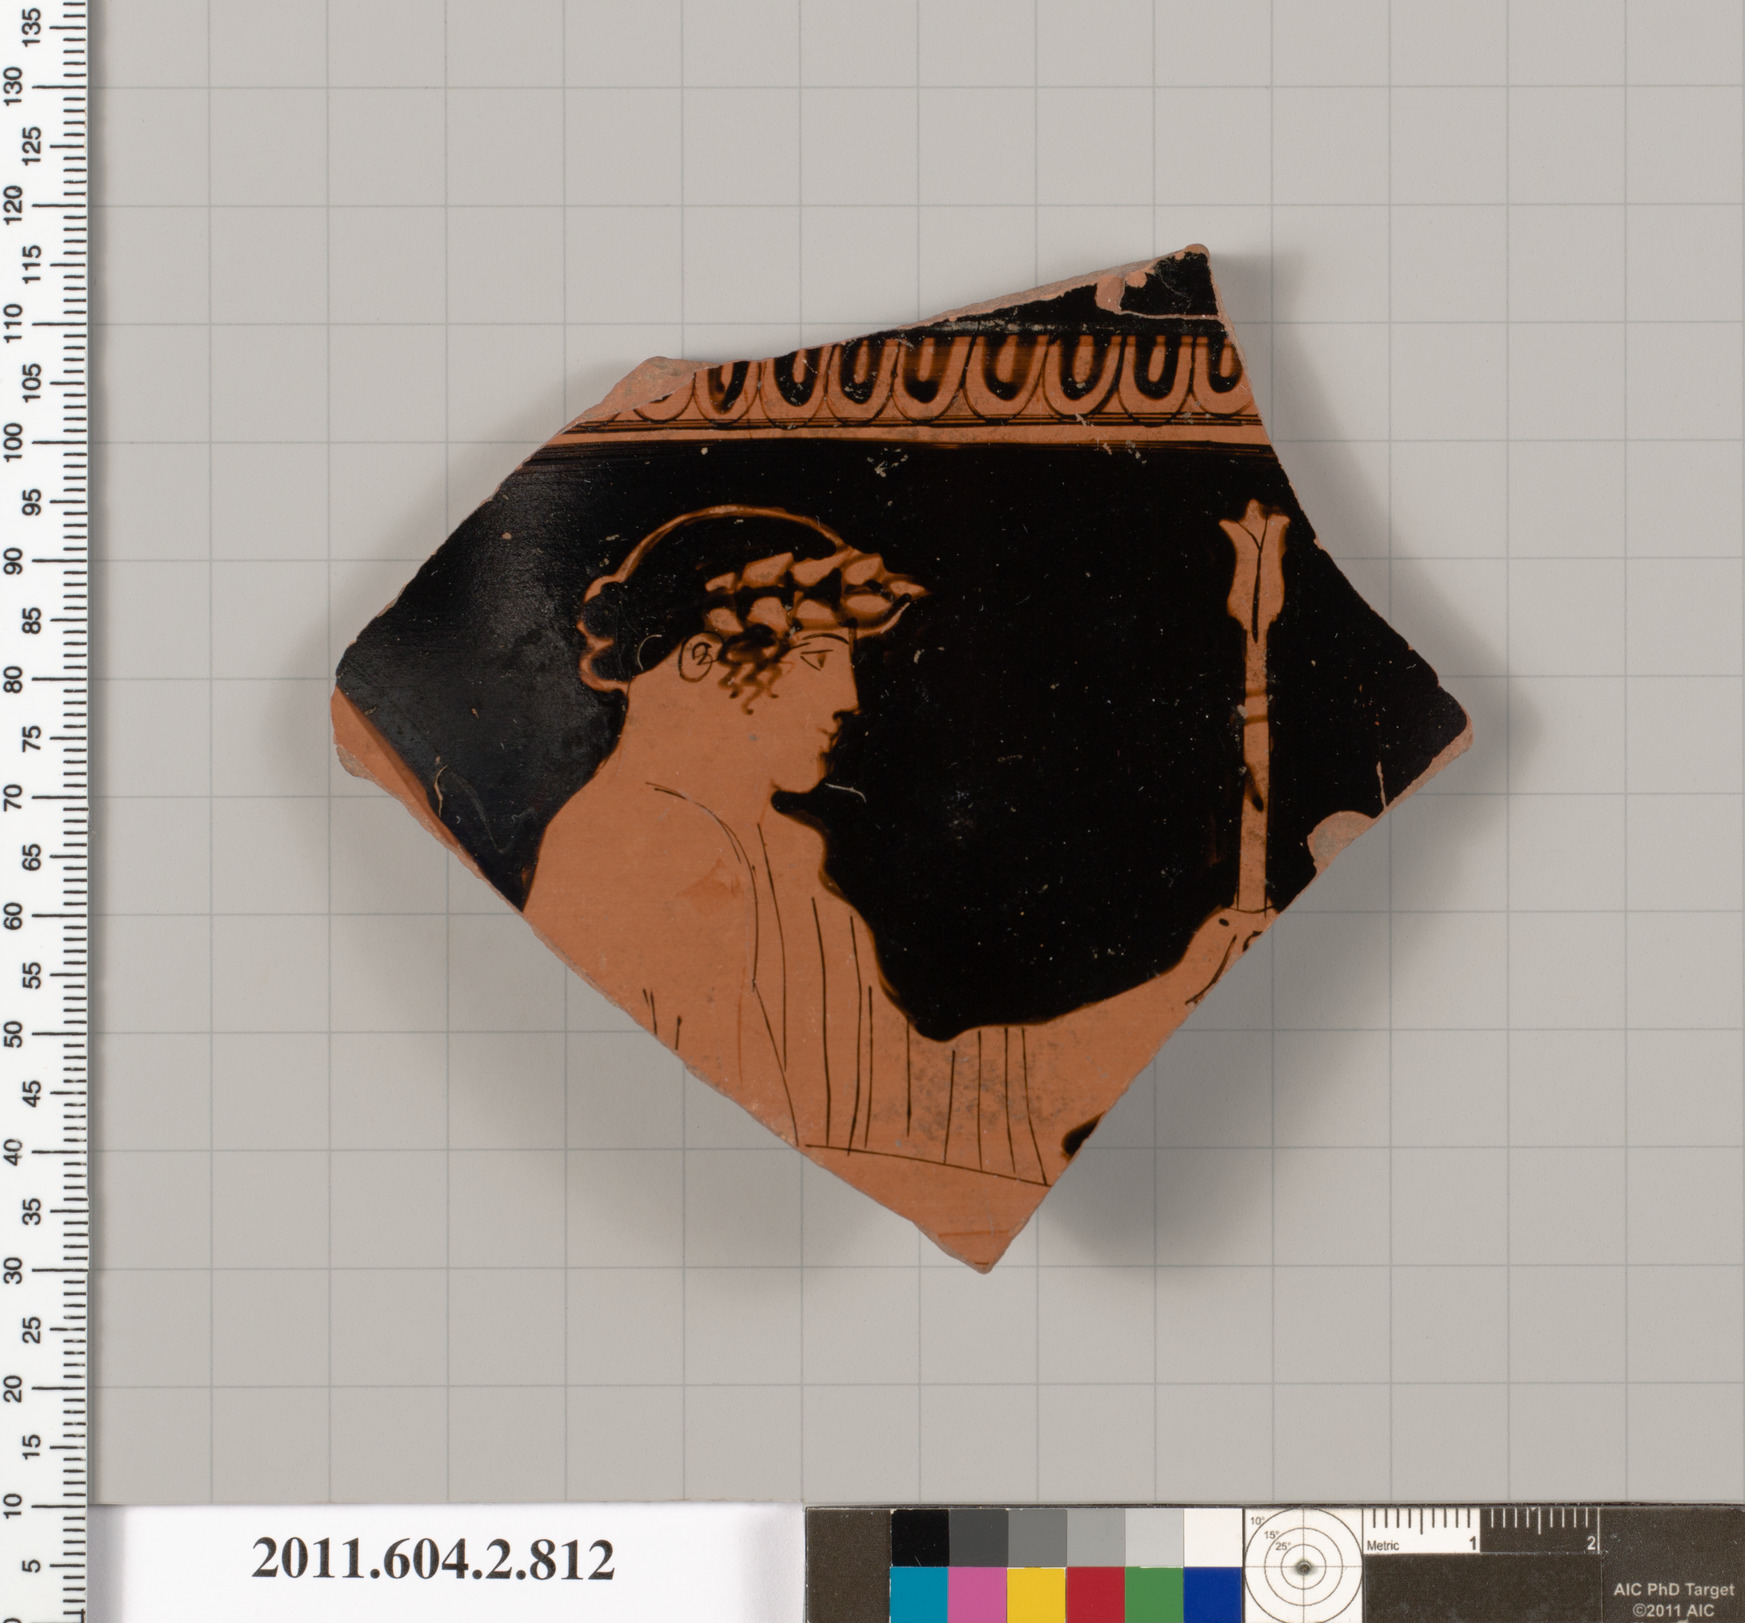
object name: bell krater fragment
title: Terracotta fragment of a bell-krater (bowl for mixing wine and water)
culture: greek, attic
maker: altamura painter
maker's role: artist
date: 470-460 BCE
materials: terracotta